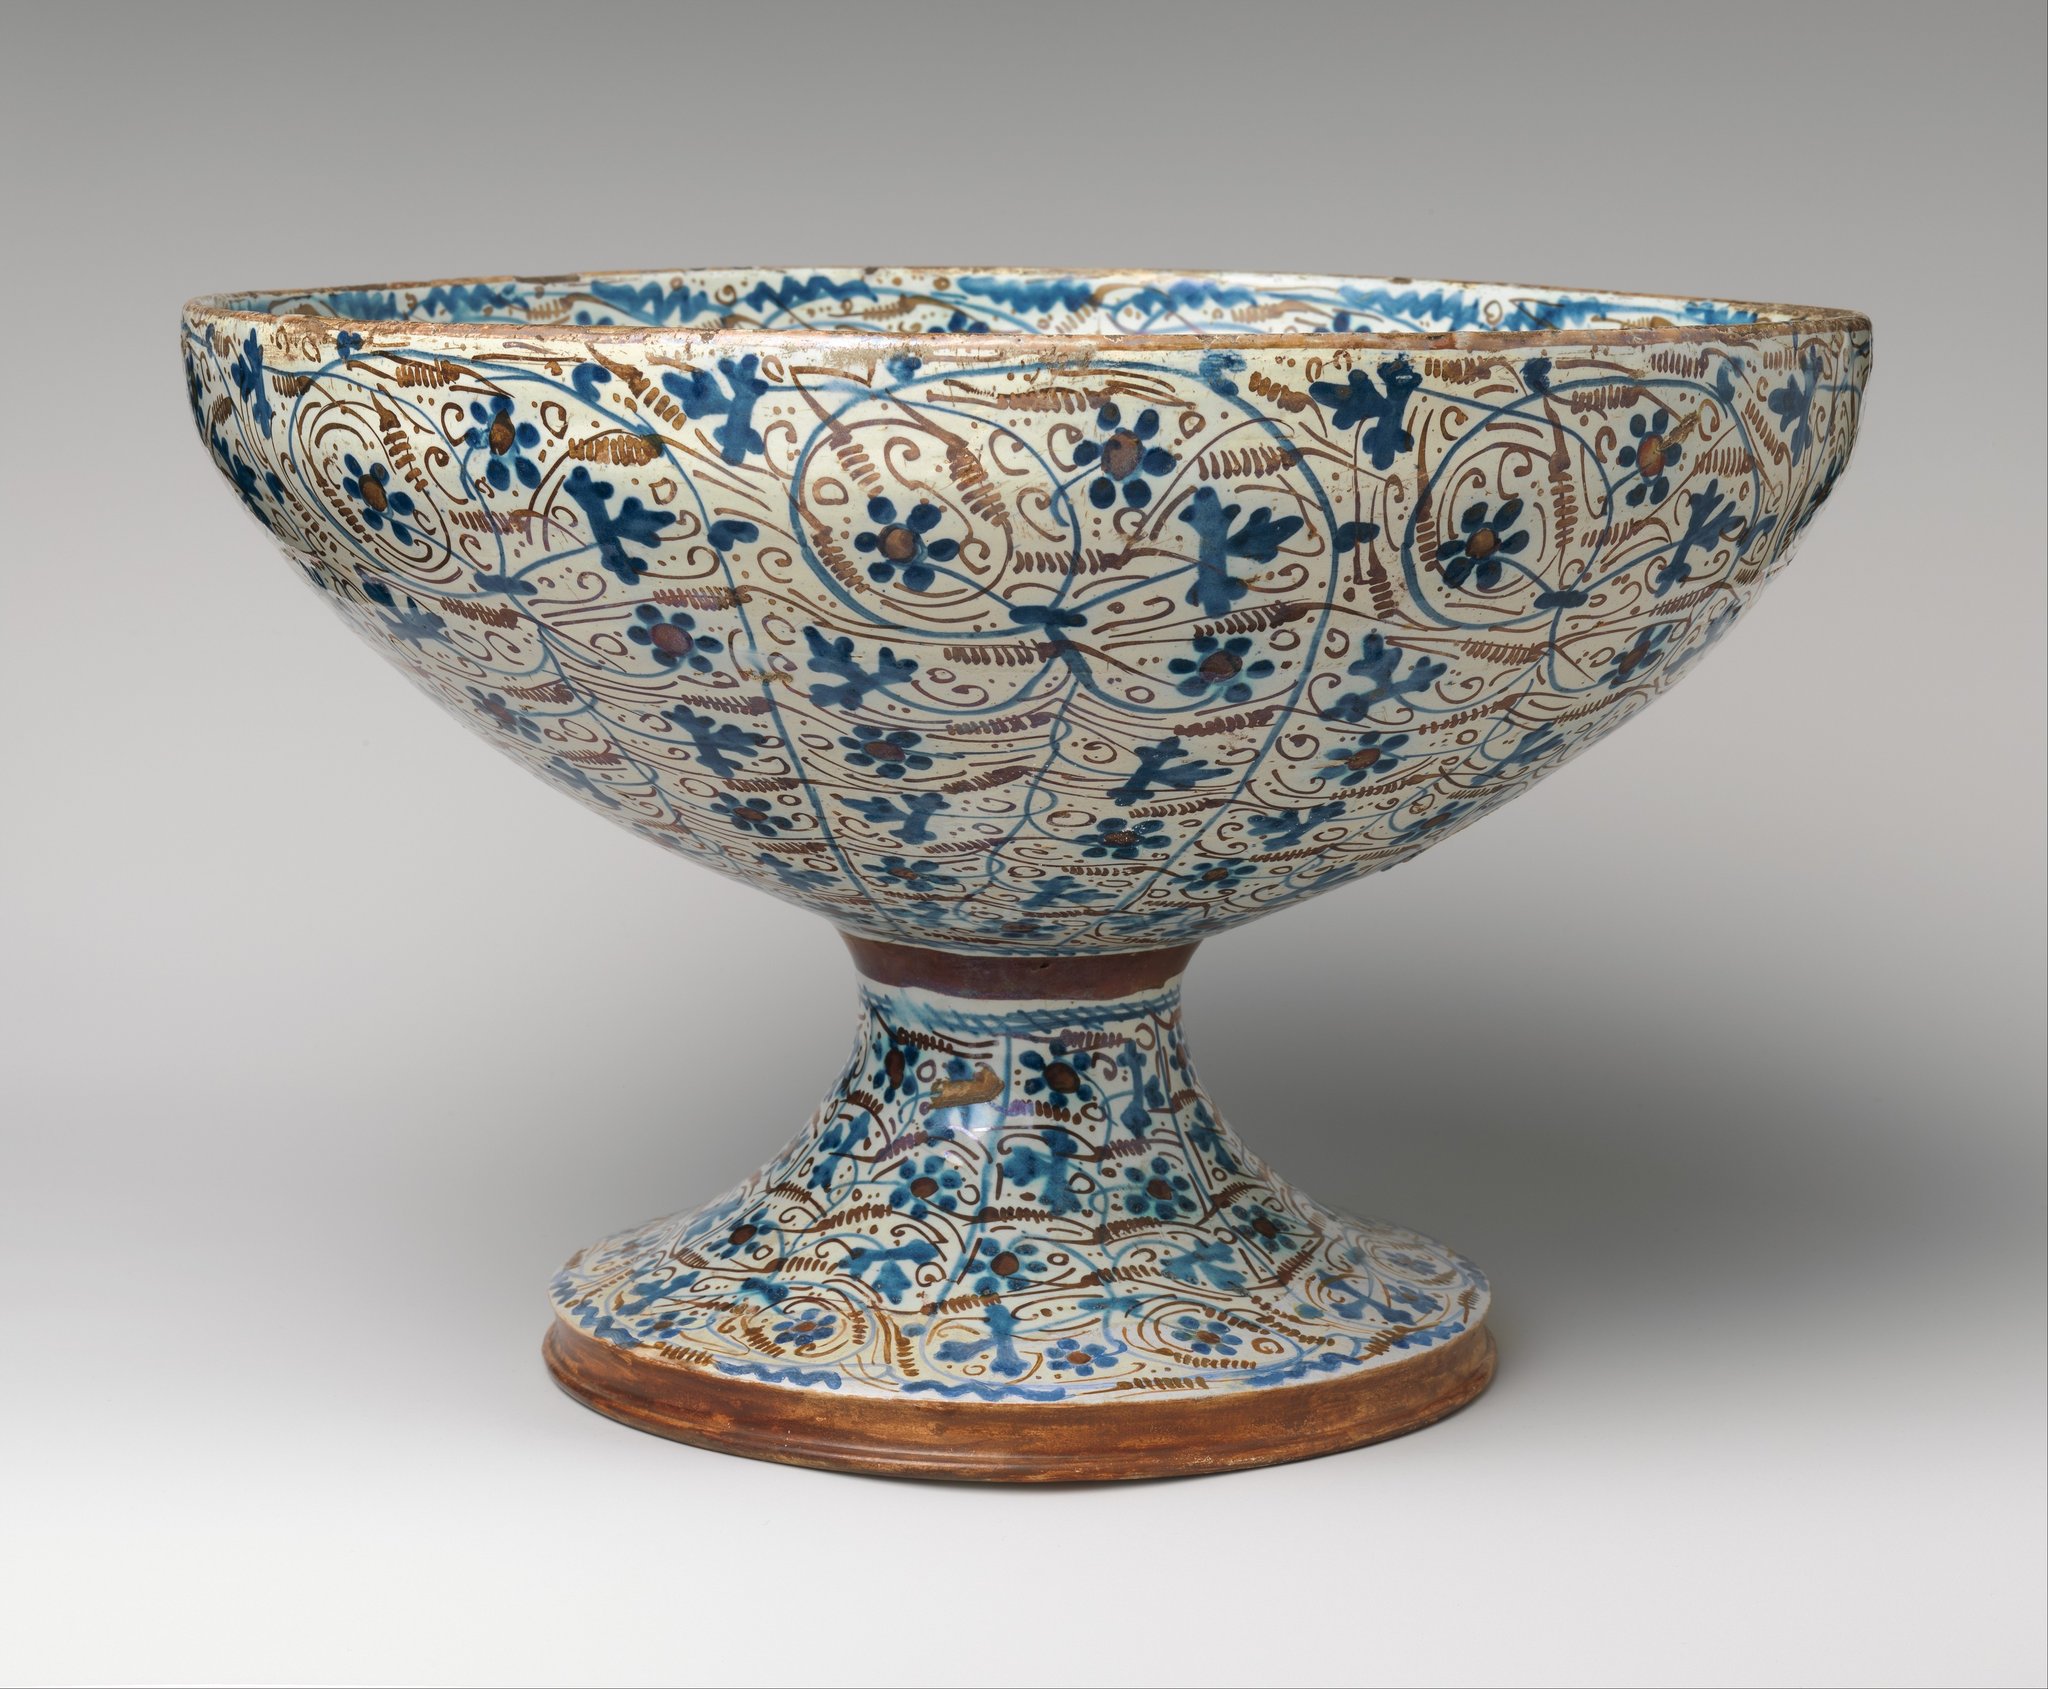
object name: bowl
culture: spanish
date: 1440-1460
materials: earthenware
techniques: glazing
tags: flowers,insignia